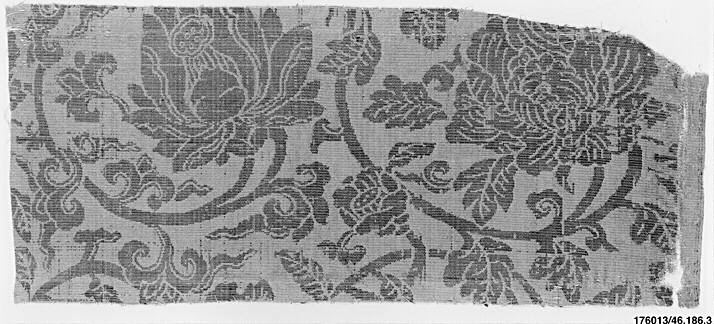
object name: sutra cover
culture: chinese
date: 1501-1700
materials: silk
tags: flowers